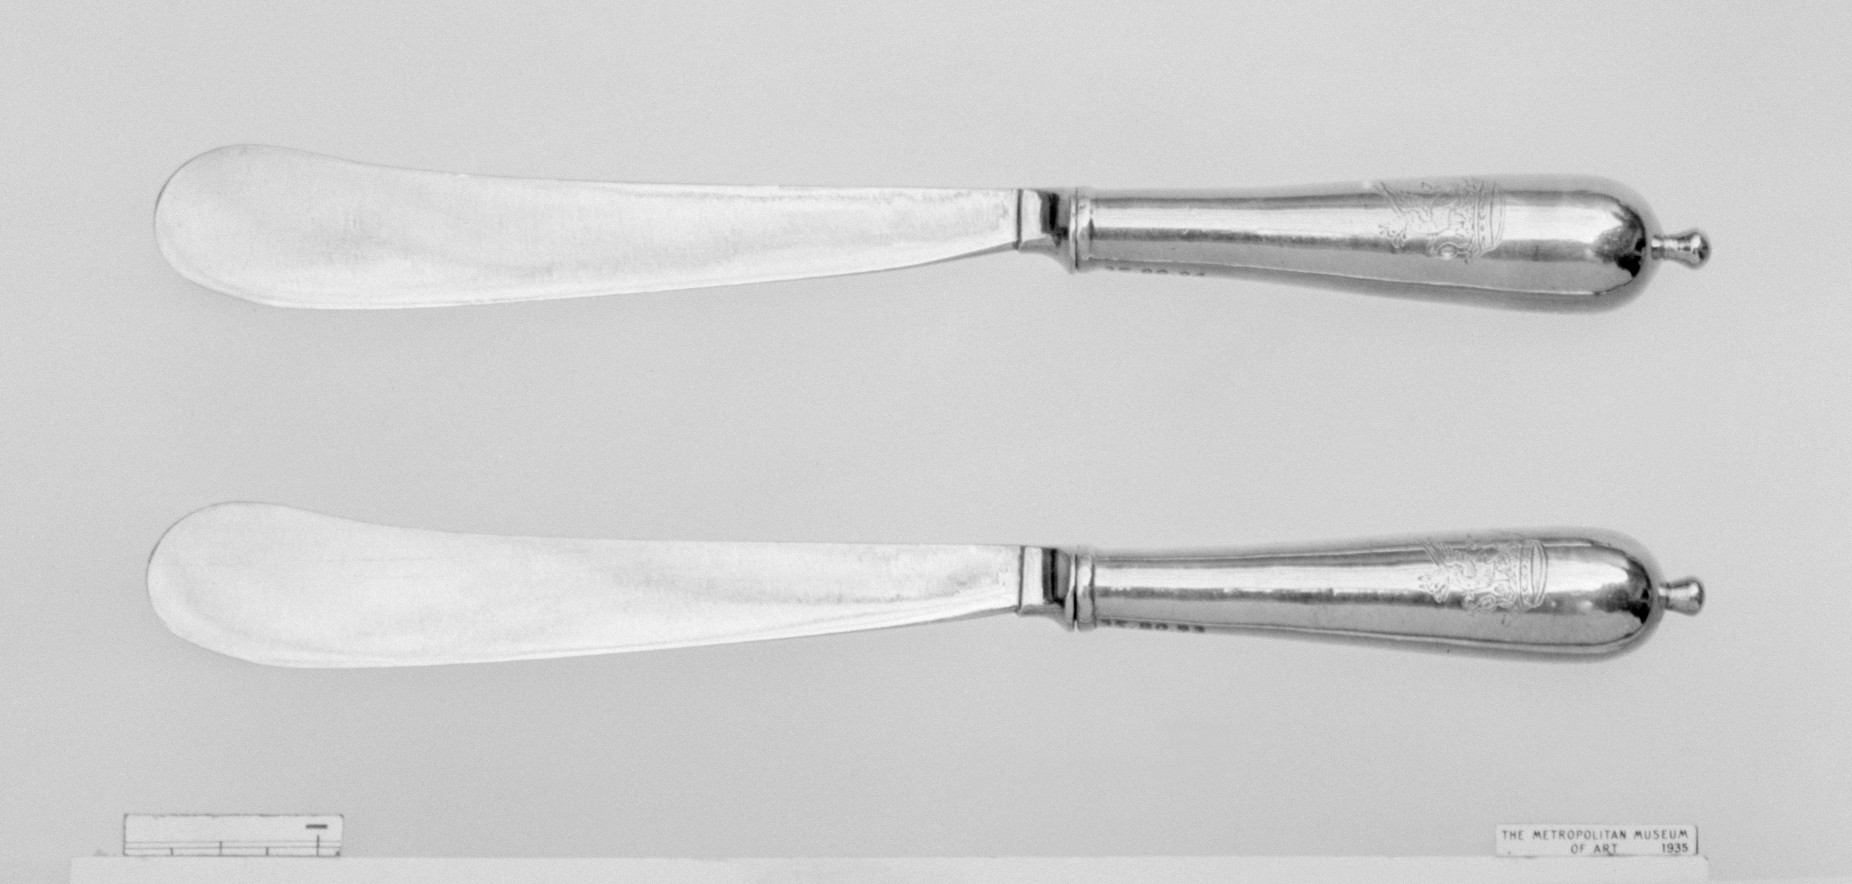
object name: knife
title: Two knives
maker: albert schurman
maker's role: maker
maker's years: 1735-1760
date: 1734-1766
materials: silver gilt